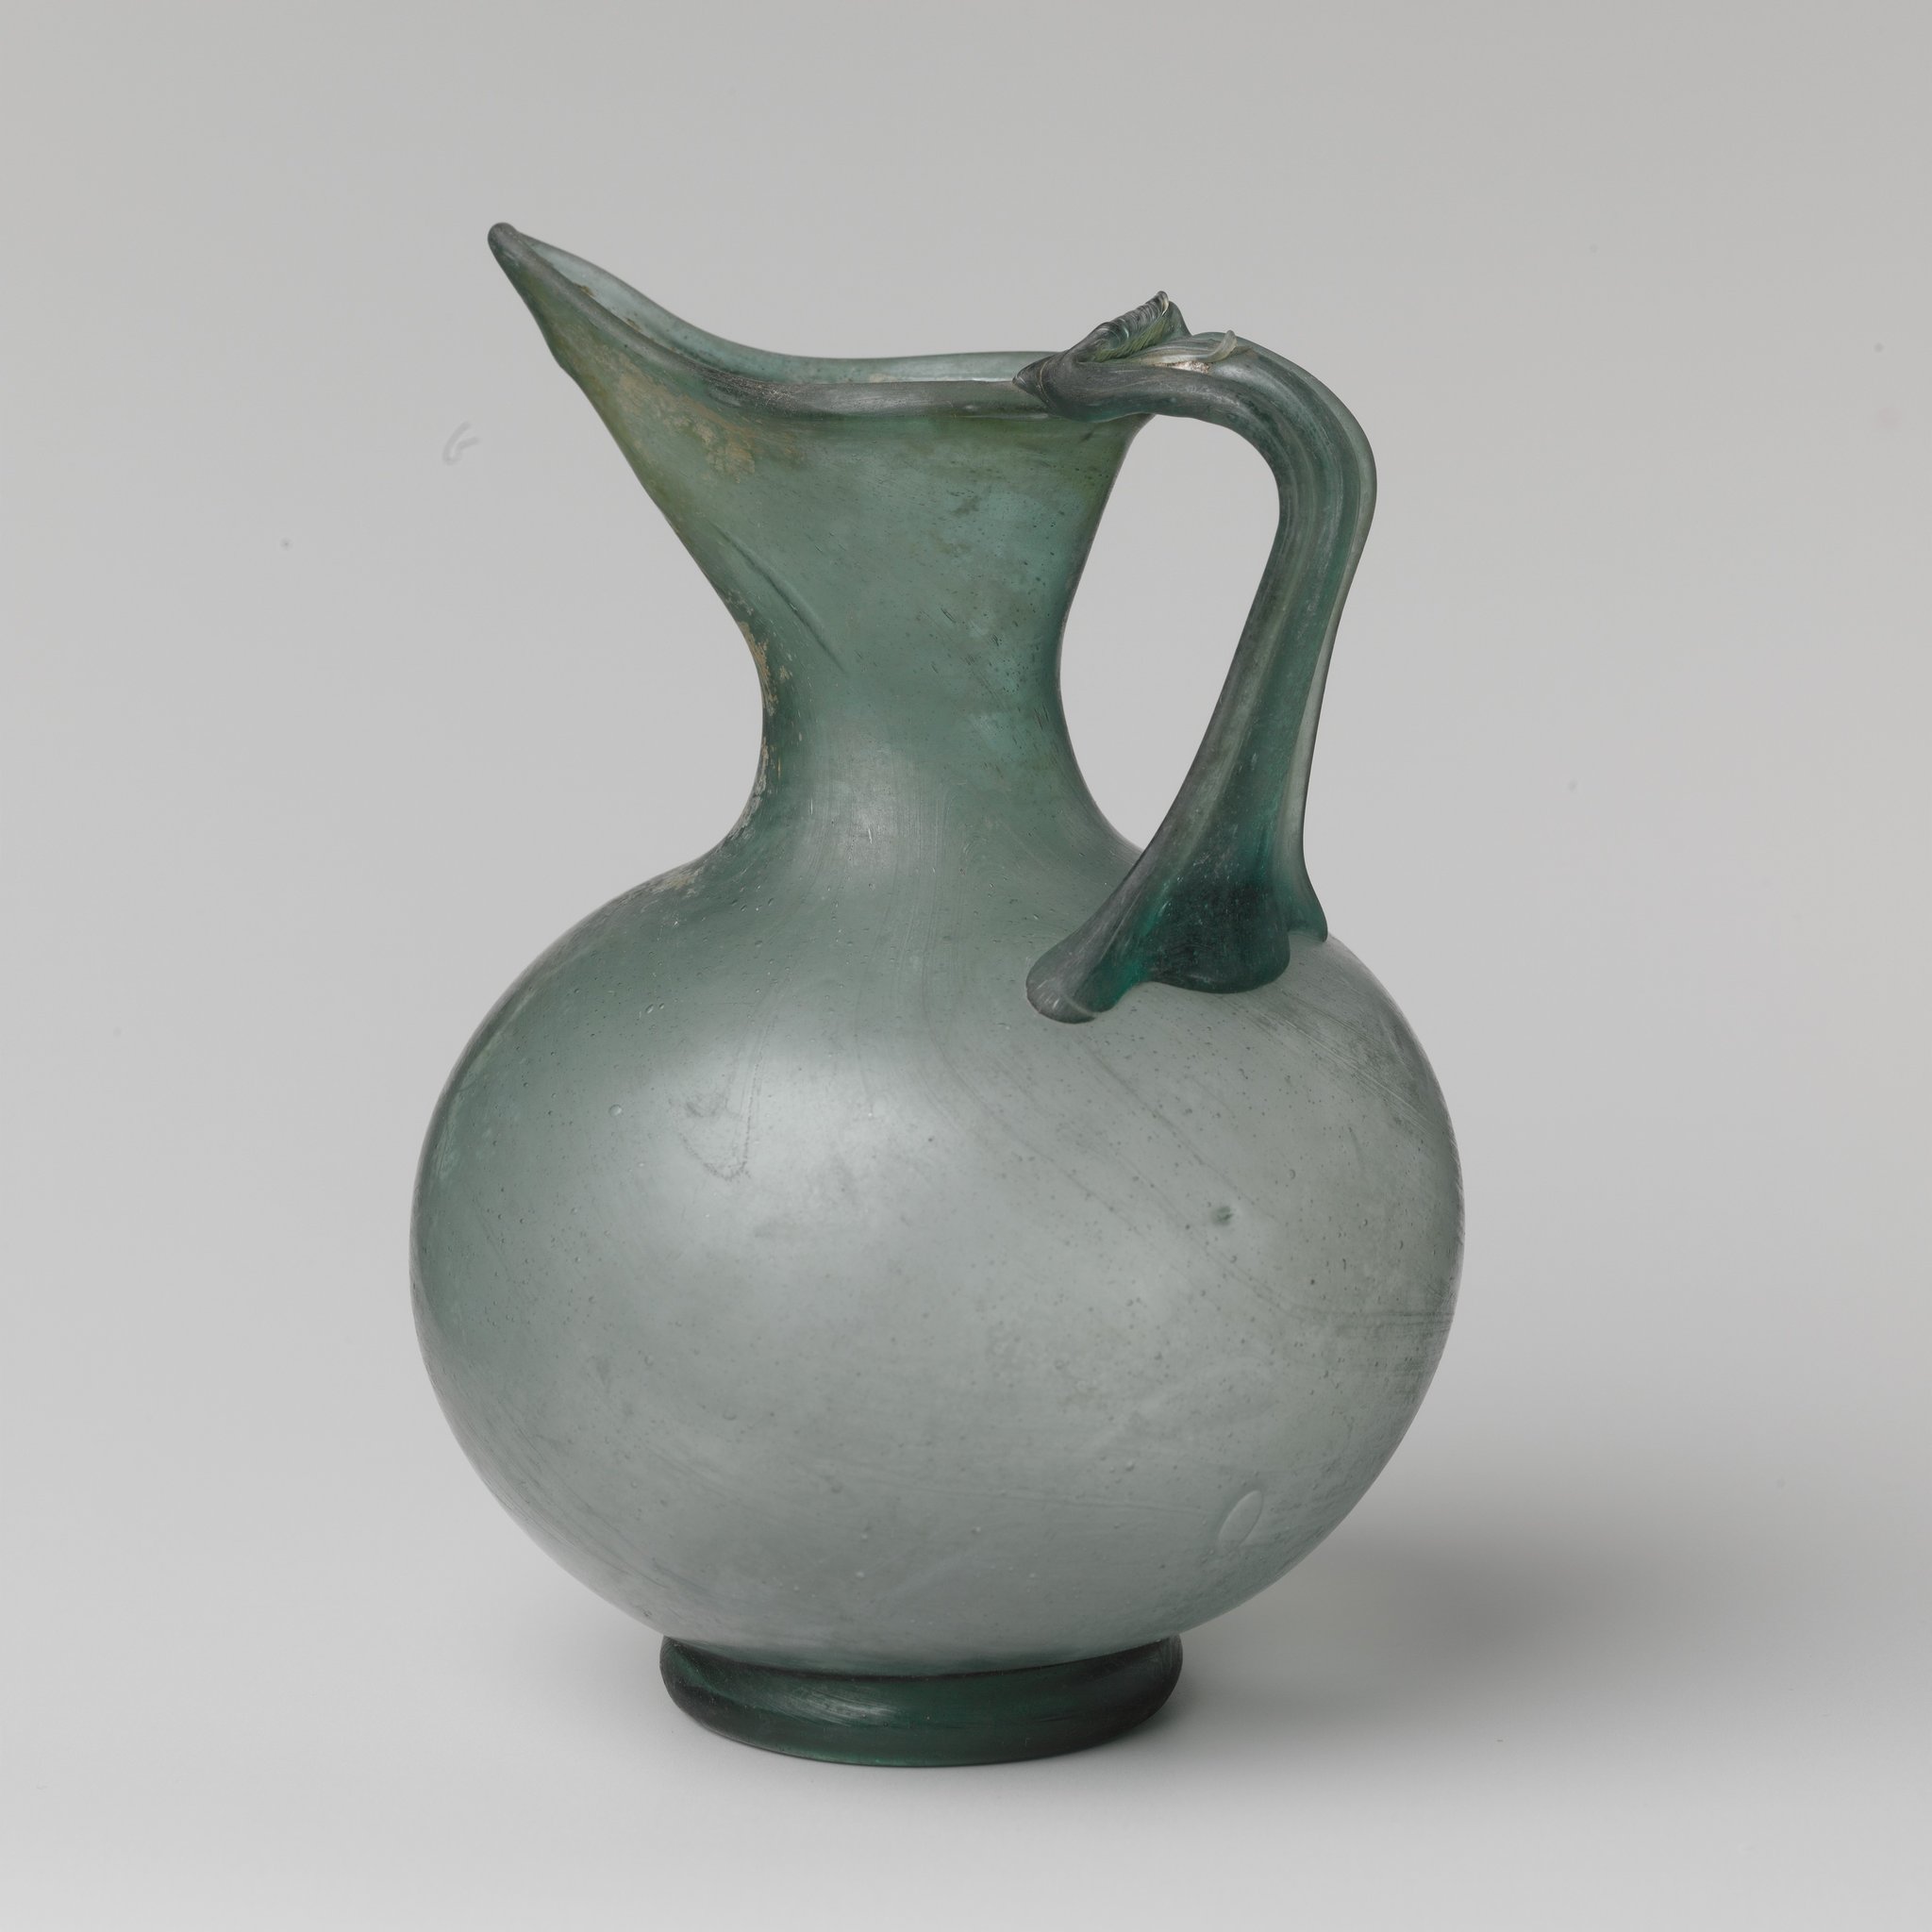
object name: jug, spouted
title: Glass spouted jug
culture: roman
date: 101-300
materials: glass